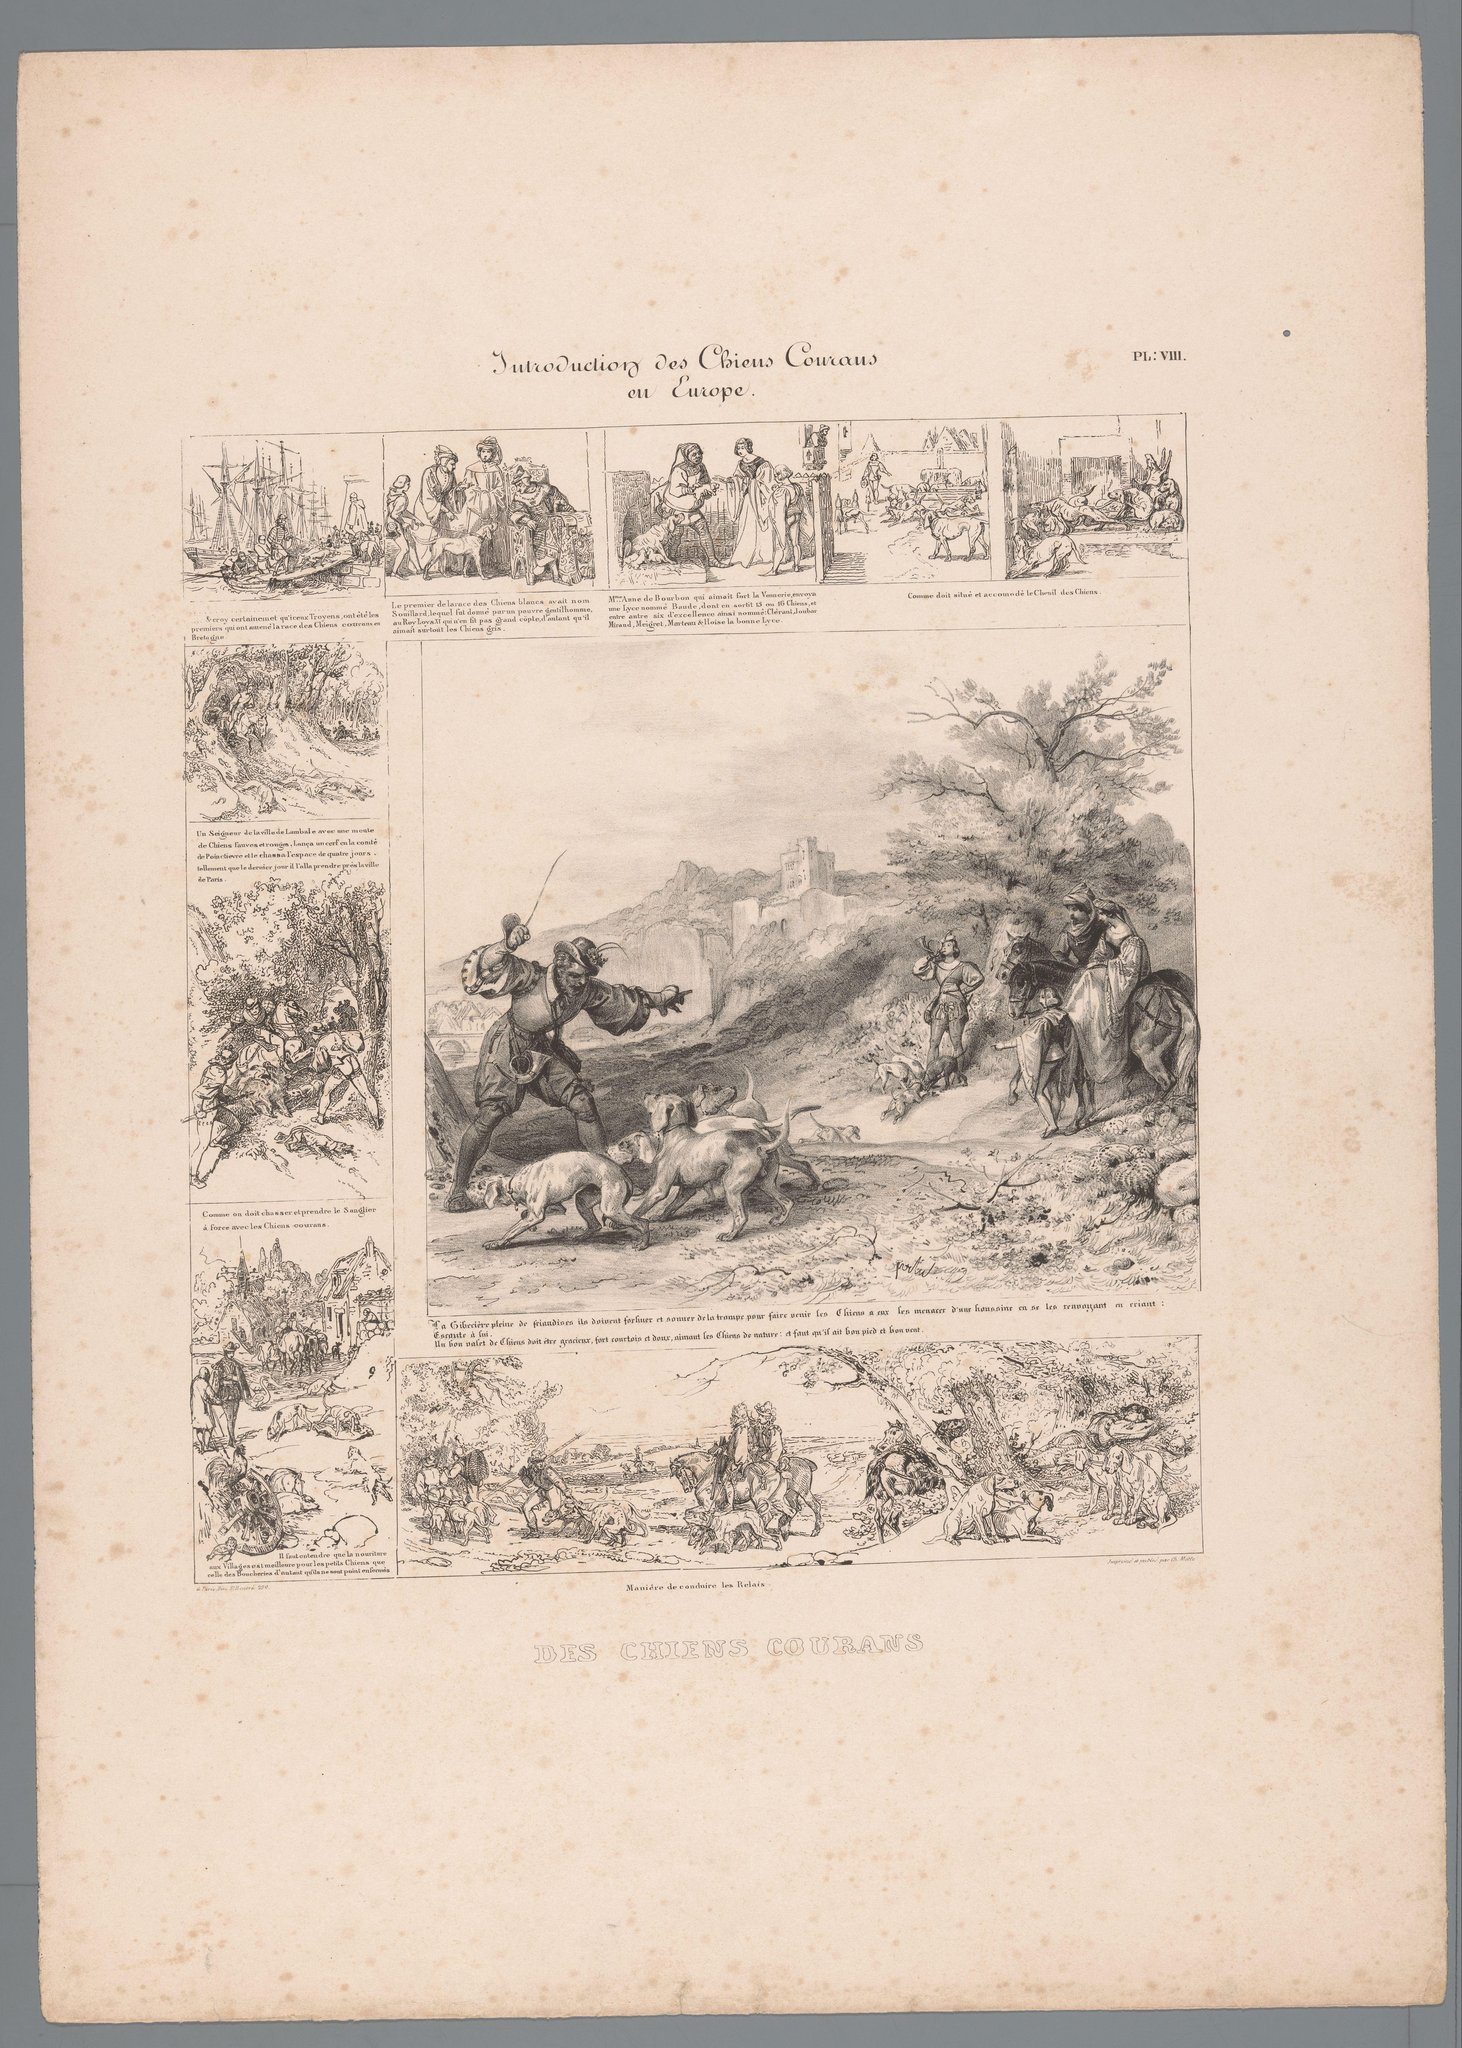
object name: print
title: Oude jachtvormen volgens middeleeuwse manuscripten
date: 1836-1837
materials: paper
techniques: lithography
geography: paris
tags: hunting, chase, hunting dogs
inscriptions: check stamp: Lugt 1828c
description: Deze prent maakt deel uit van een omslag met twaalf prenten. Rondom de hoofdvoorstelling wordt de historische achtergrond van de jachthond in Europa uitgelegd in woord en beeld.